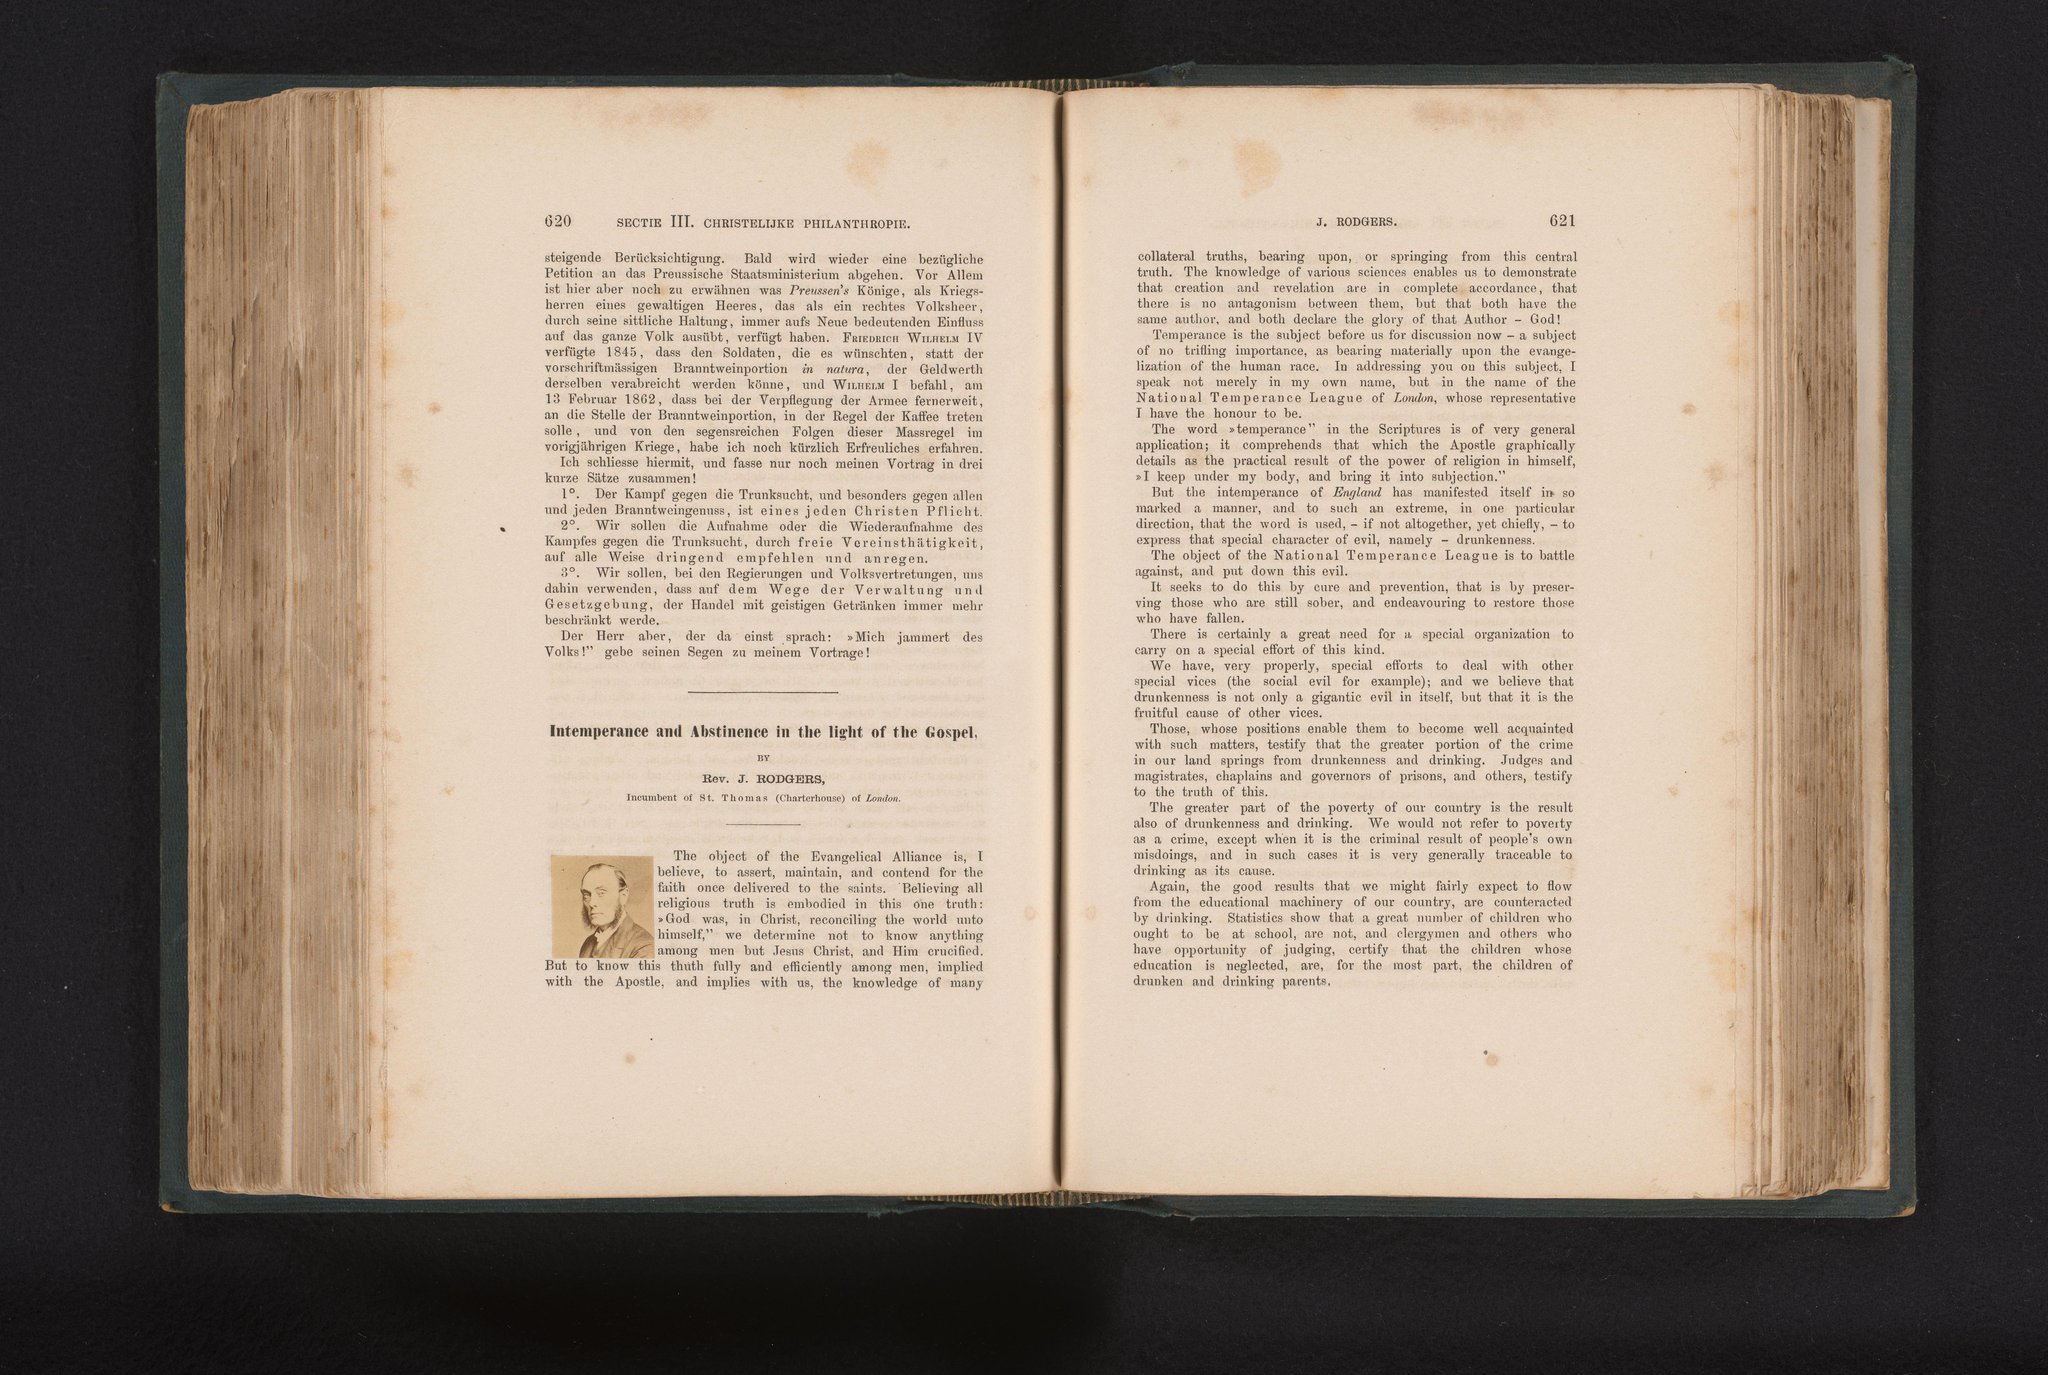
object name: page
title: Portret van predikant J. Rodgers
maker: Anonymous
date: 1855-1867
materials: paper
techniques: albumen print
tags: adult man, historical persons